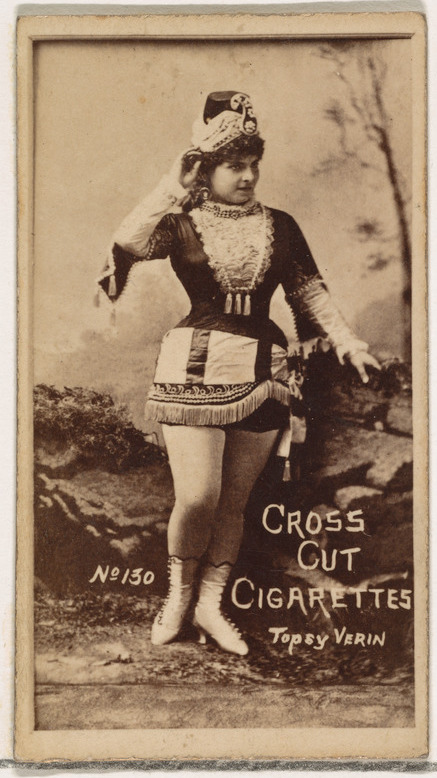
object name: print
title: Card Number 130, Topsy Verin, from the Actors and Actresses series (N145-1) issued by Duke Sons & Co. to promote Cross Cut Cigarettes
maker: w. duke, sons & co.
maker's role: publisher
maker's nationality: american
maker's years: 1870-1920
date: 1880-1889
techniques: albumen silver print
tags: portraits,women,actresses